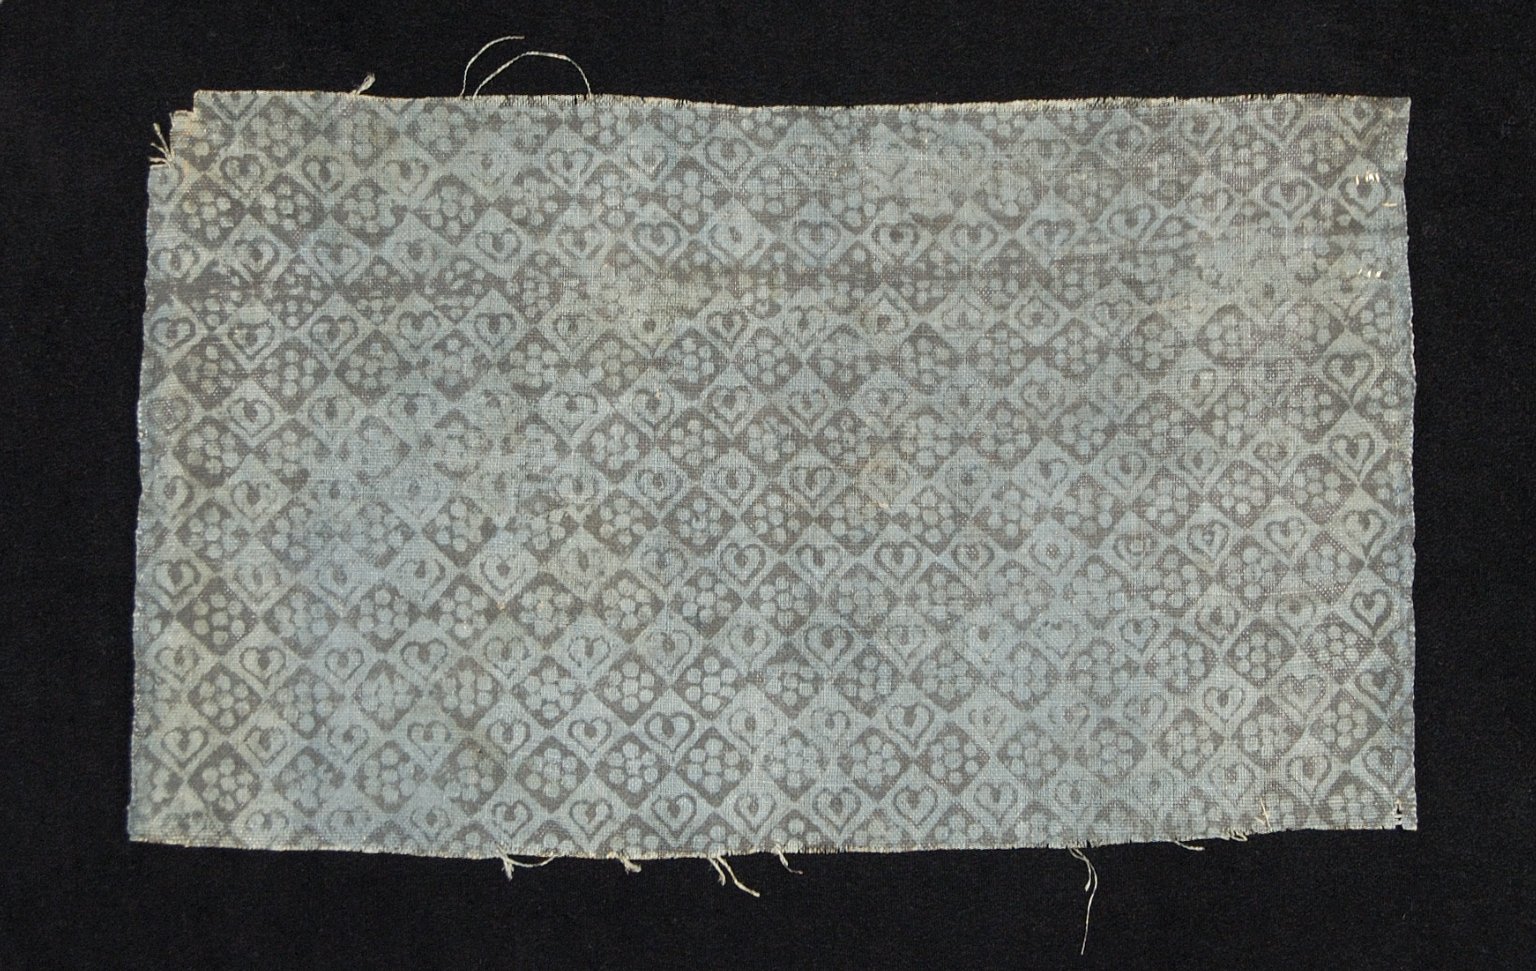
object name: textile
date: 1700-1899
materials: linen